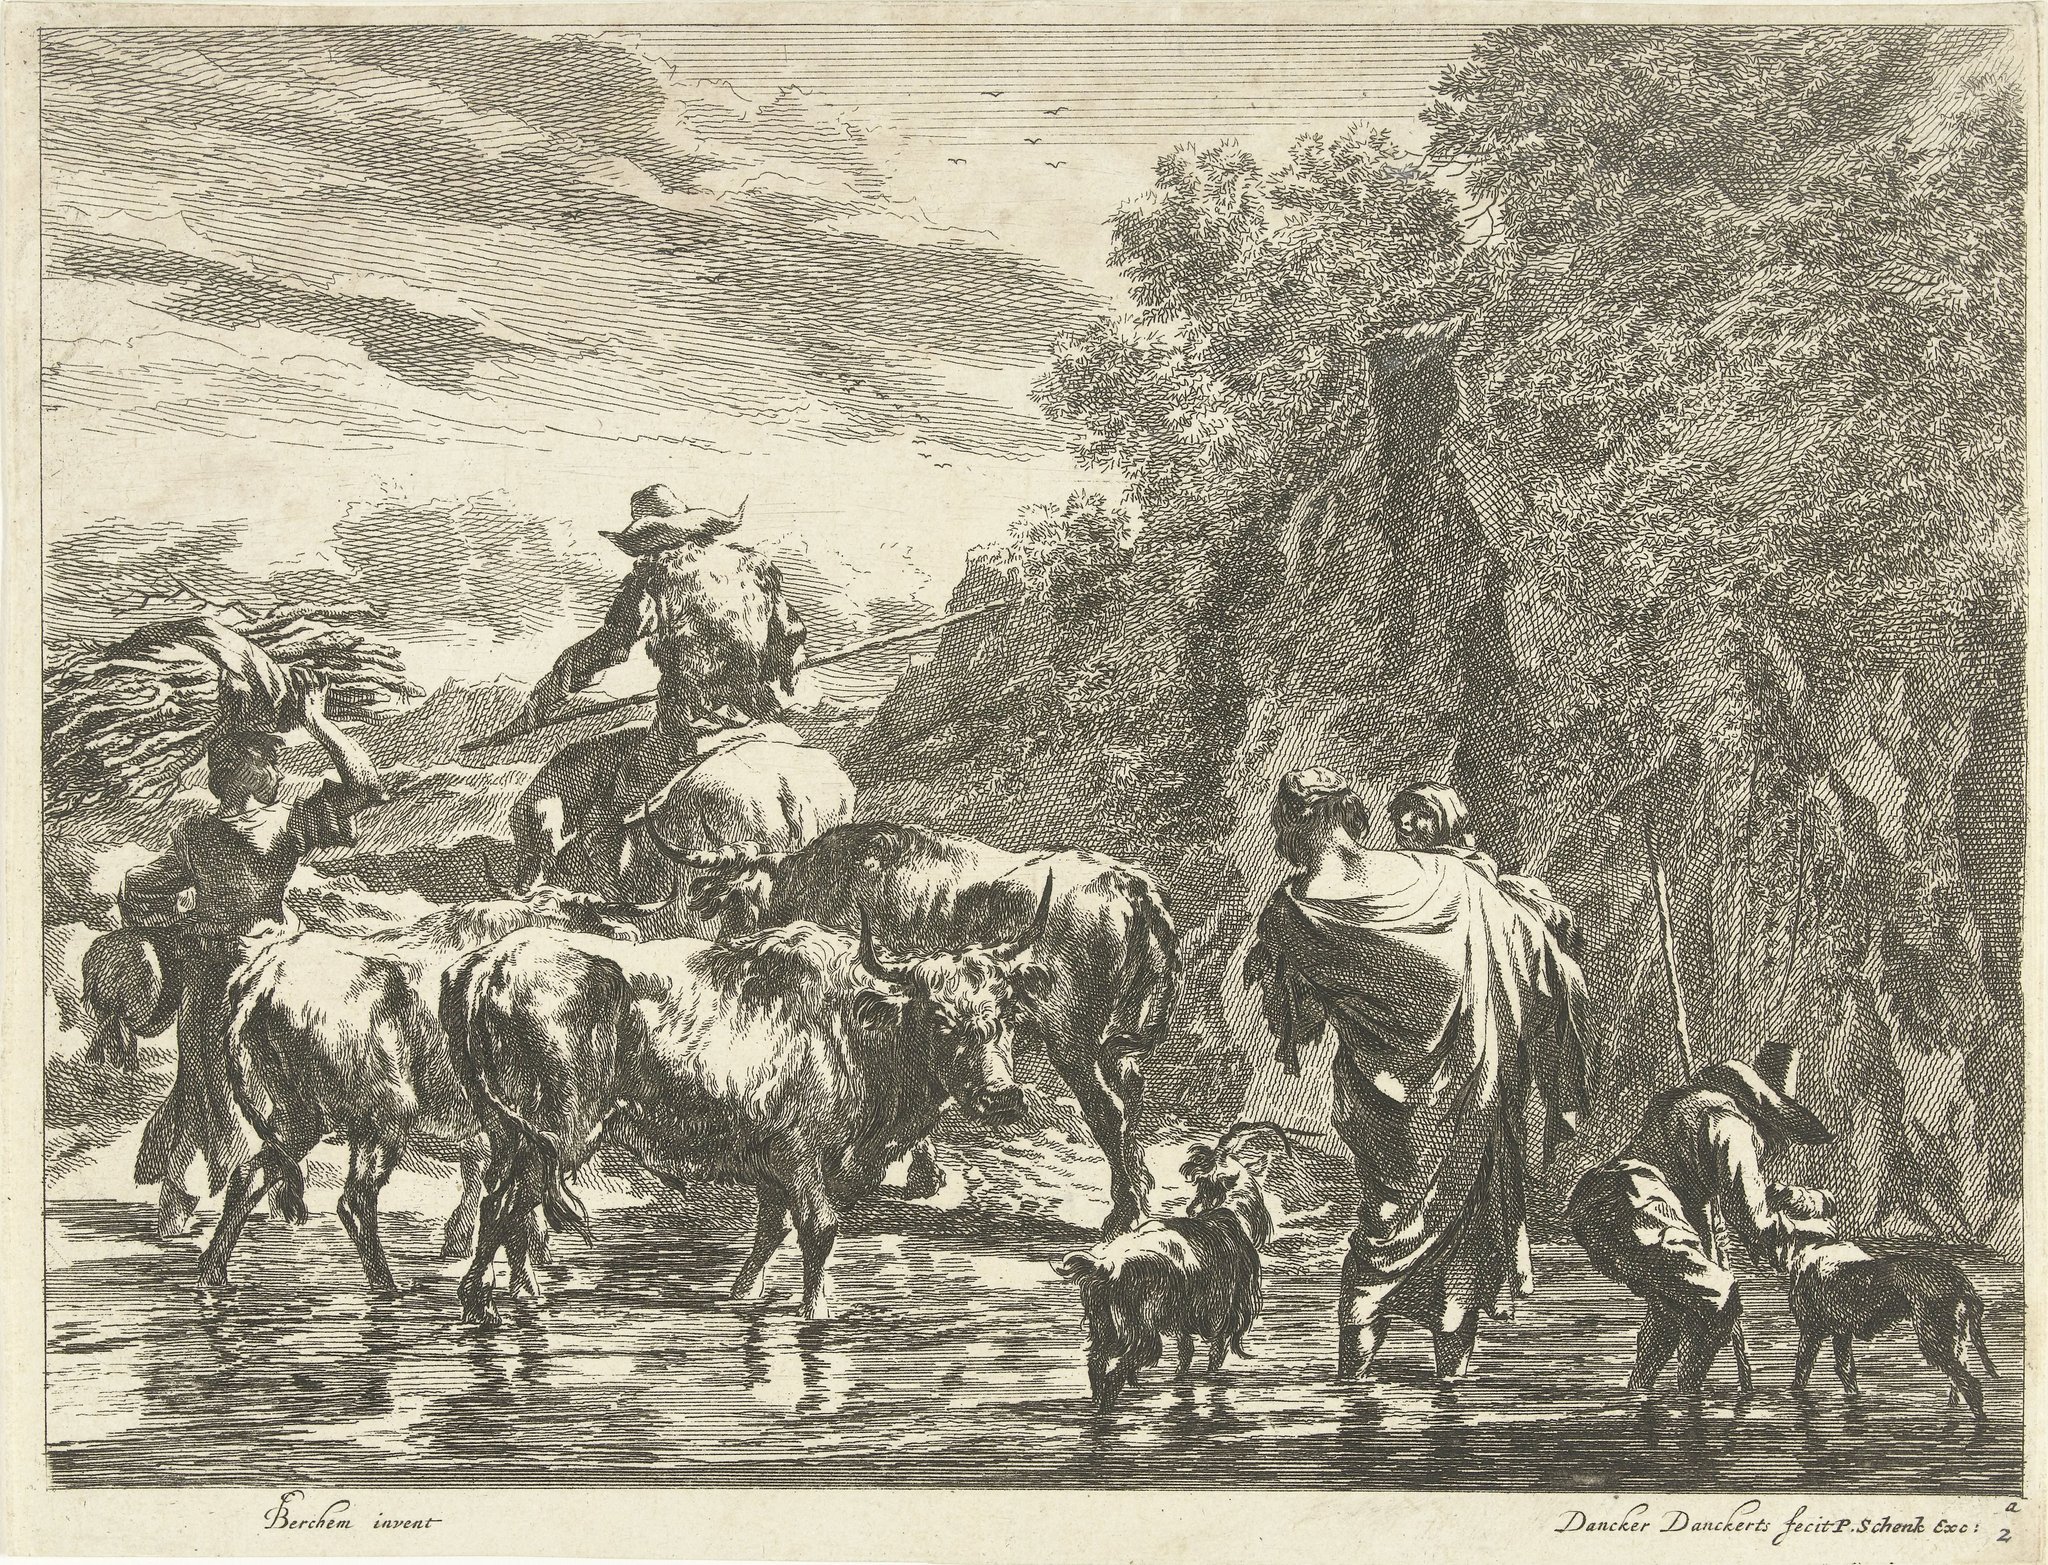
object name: print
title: Herders waden met kudde koeien door beek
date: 1643-1666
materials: paper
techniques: etching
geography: amsterdam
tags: crossing a river, herding, herdsman, herdswoman, shepherd, shepherdess, cowherd, etc., rocks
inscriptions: collector's mark: Lugt 2228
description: Prent uit serie van zes landschappen naar ontwerp van Nicolaes Pietersz. Berchem. De nummering van de serie in de derde staat wijkt mogelijk af van de samenstelling in voorgaande staten. Het is onduidelijk waar de letter a voor staat, deze komt terug op enkele prenten in de uitgave van Petrus Schenk of Frederik de Wit.